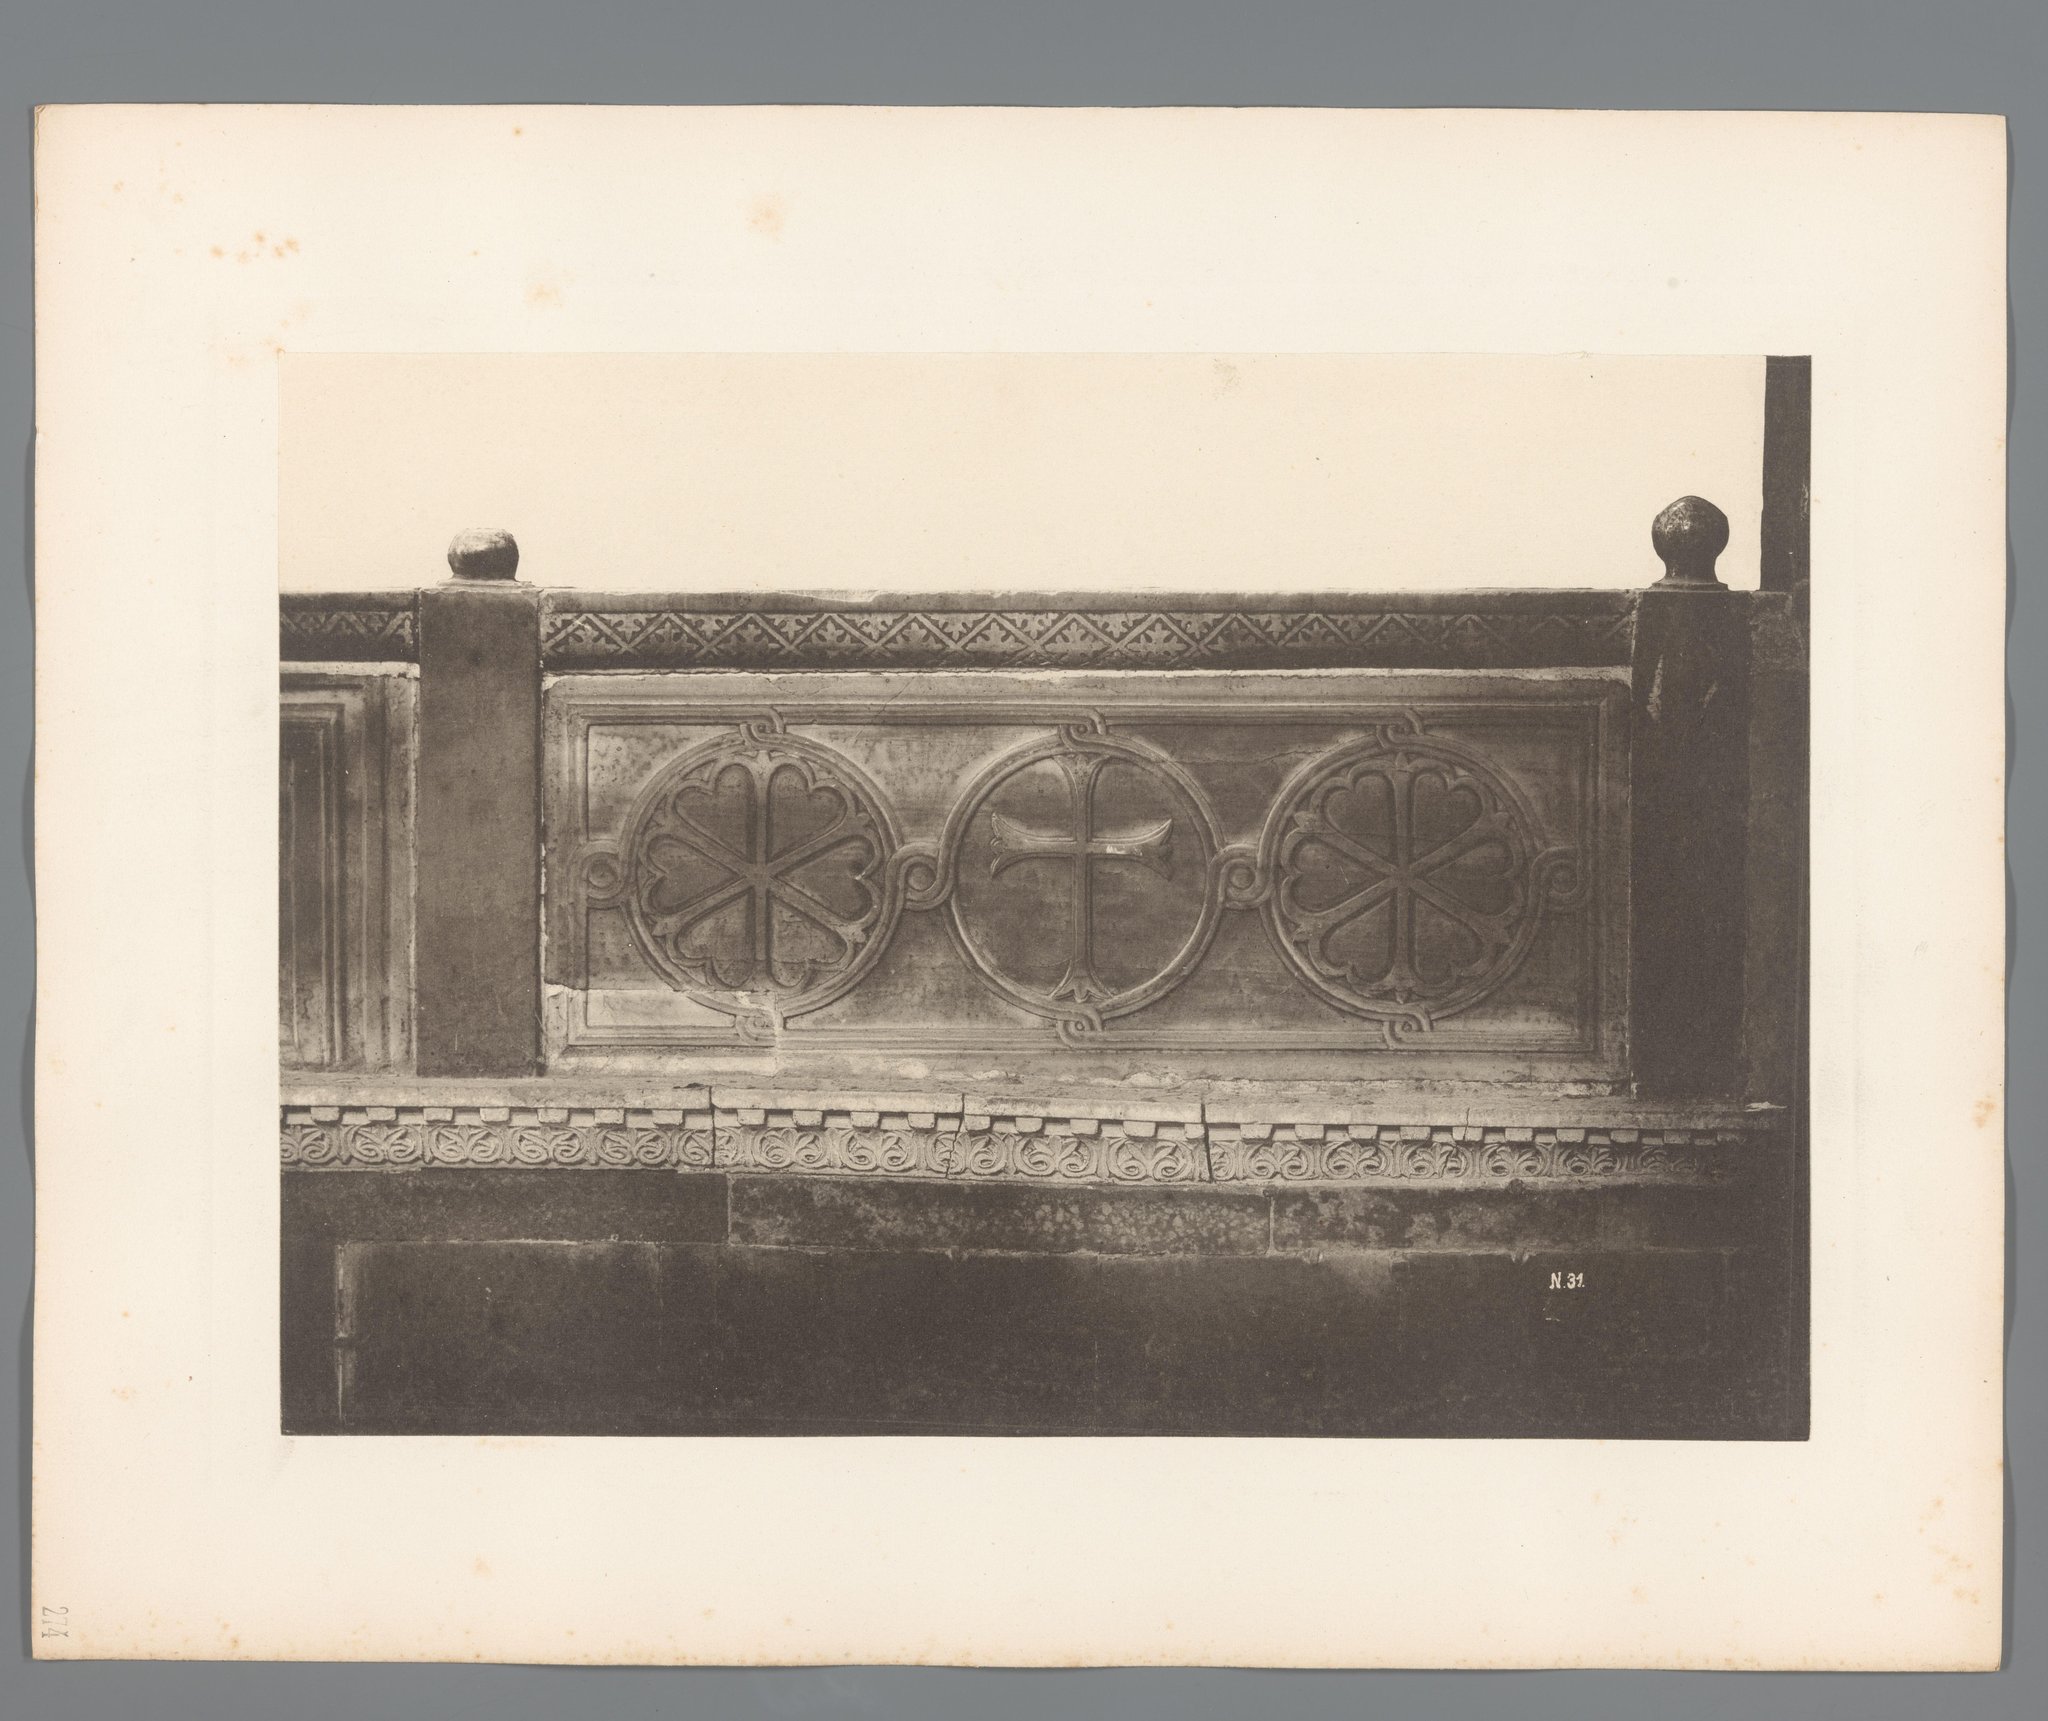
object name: photomechanical print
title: Balustrade met reliëf van de San Marco in Venetië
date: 1880-1885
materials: paper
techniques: photograph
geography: venice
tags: balustrade, piece of sculpture, reproduction of a piece of sculpture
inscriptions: number: ‘N.31.’, number: ‘274’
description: Deze prent maakt deel uit van een omslag met 58 prenten op 50 bladen.